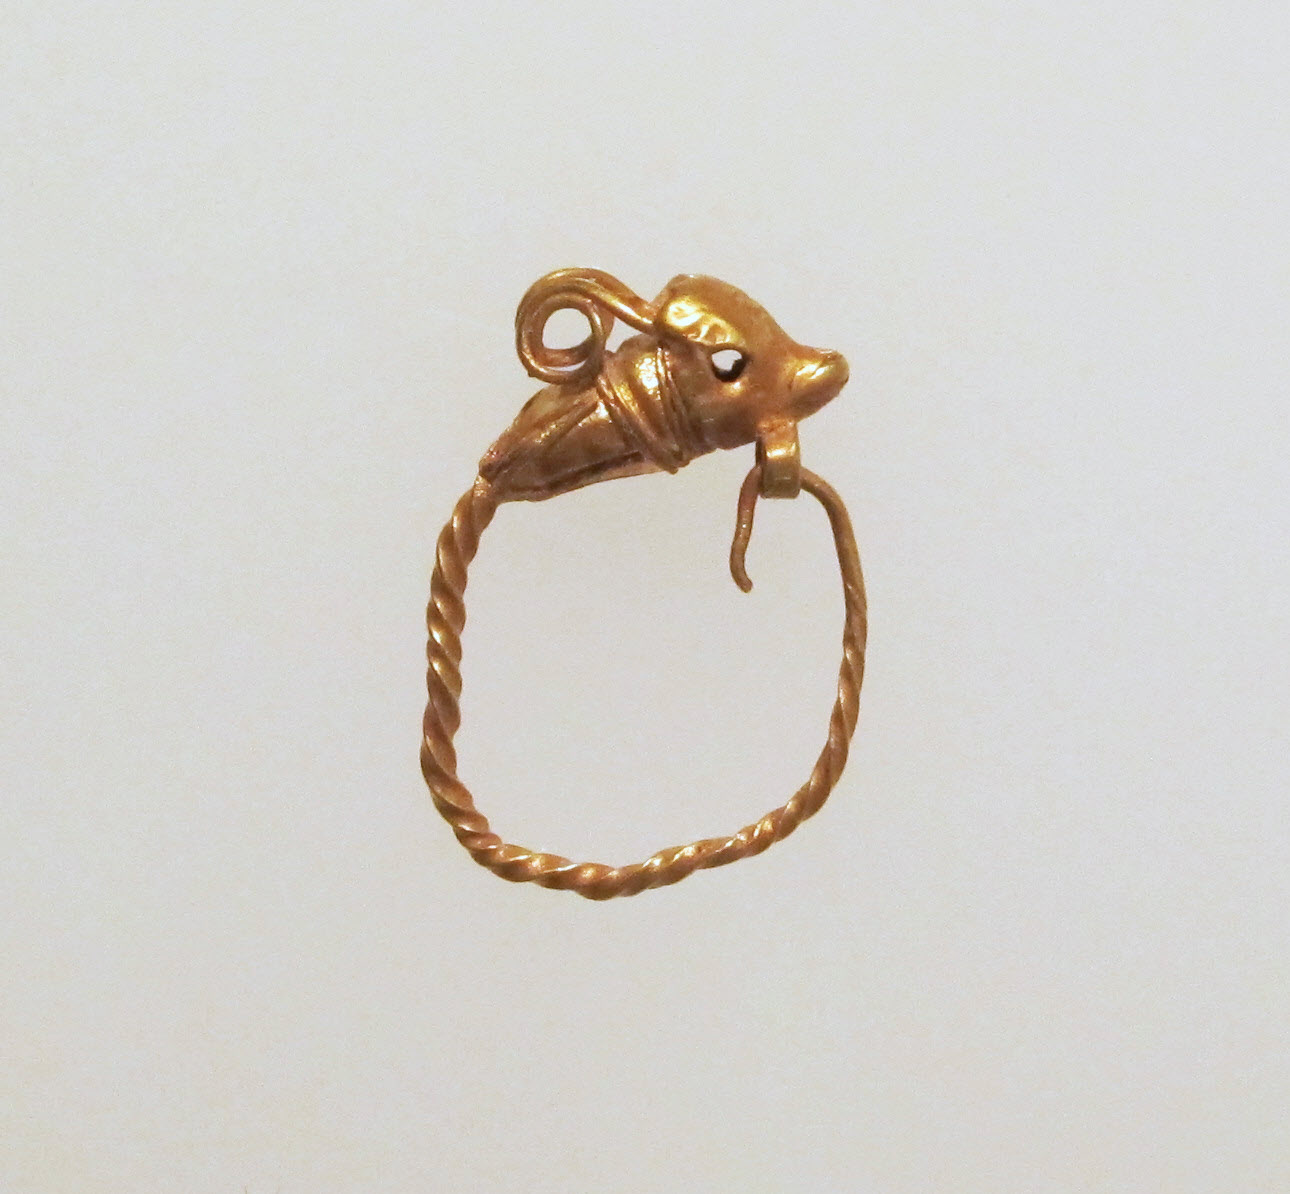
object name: earring with head of dolphin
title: Gold earring with head of a dolphin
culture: greek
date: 400-201 BCE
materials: gold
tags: dolphins